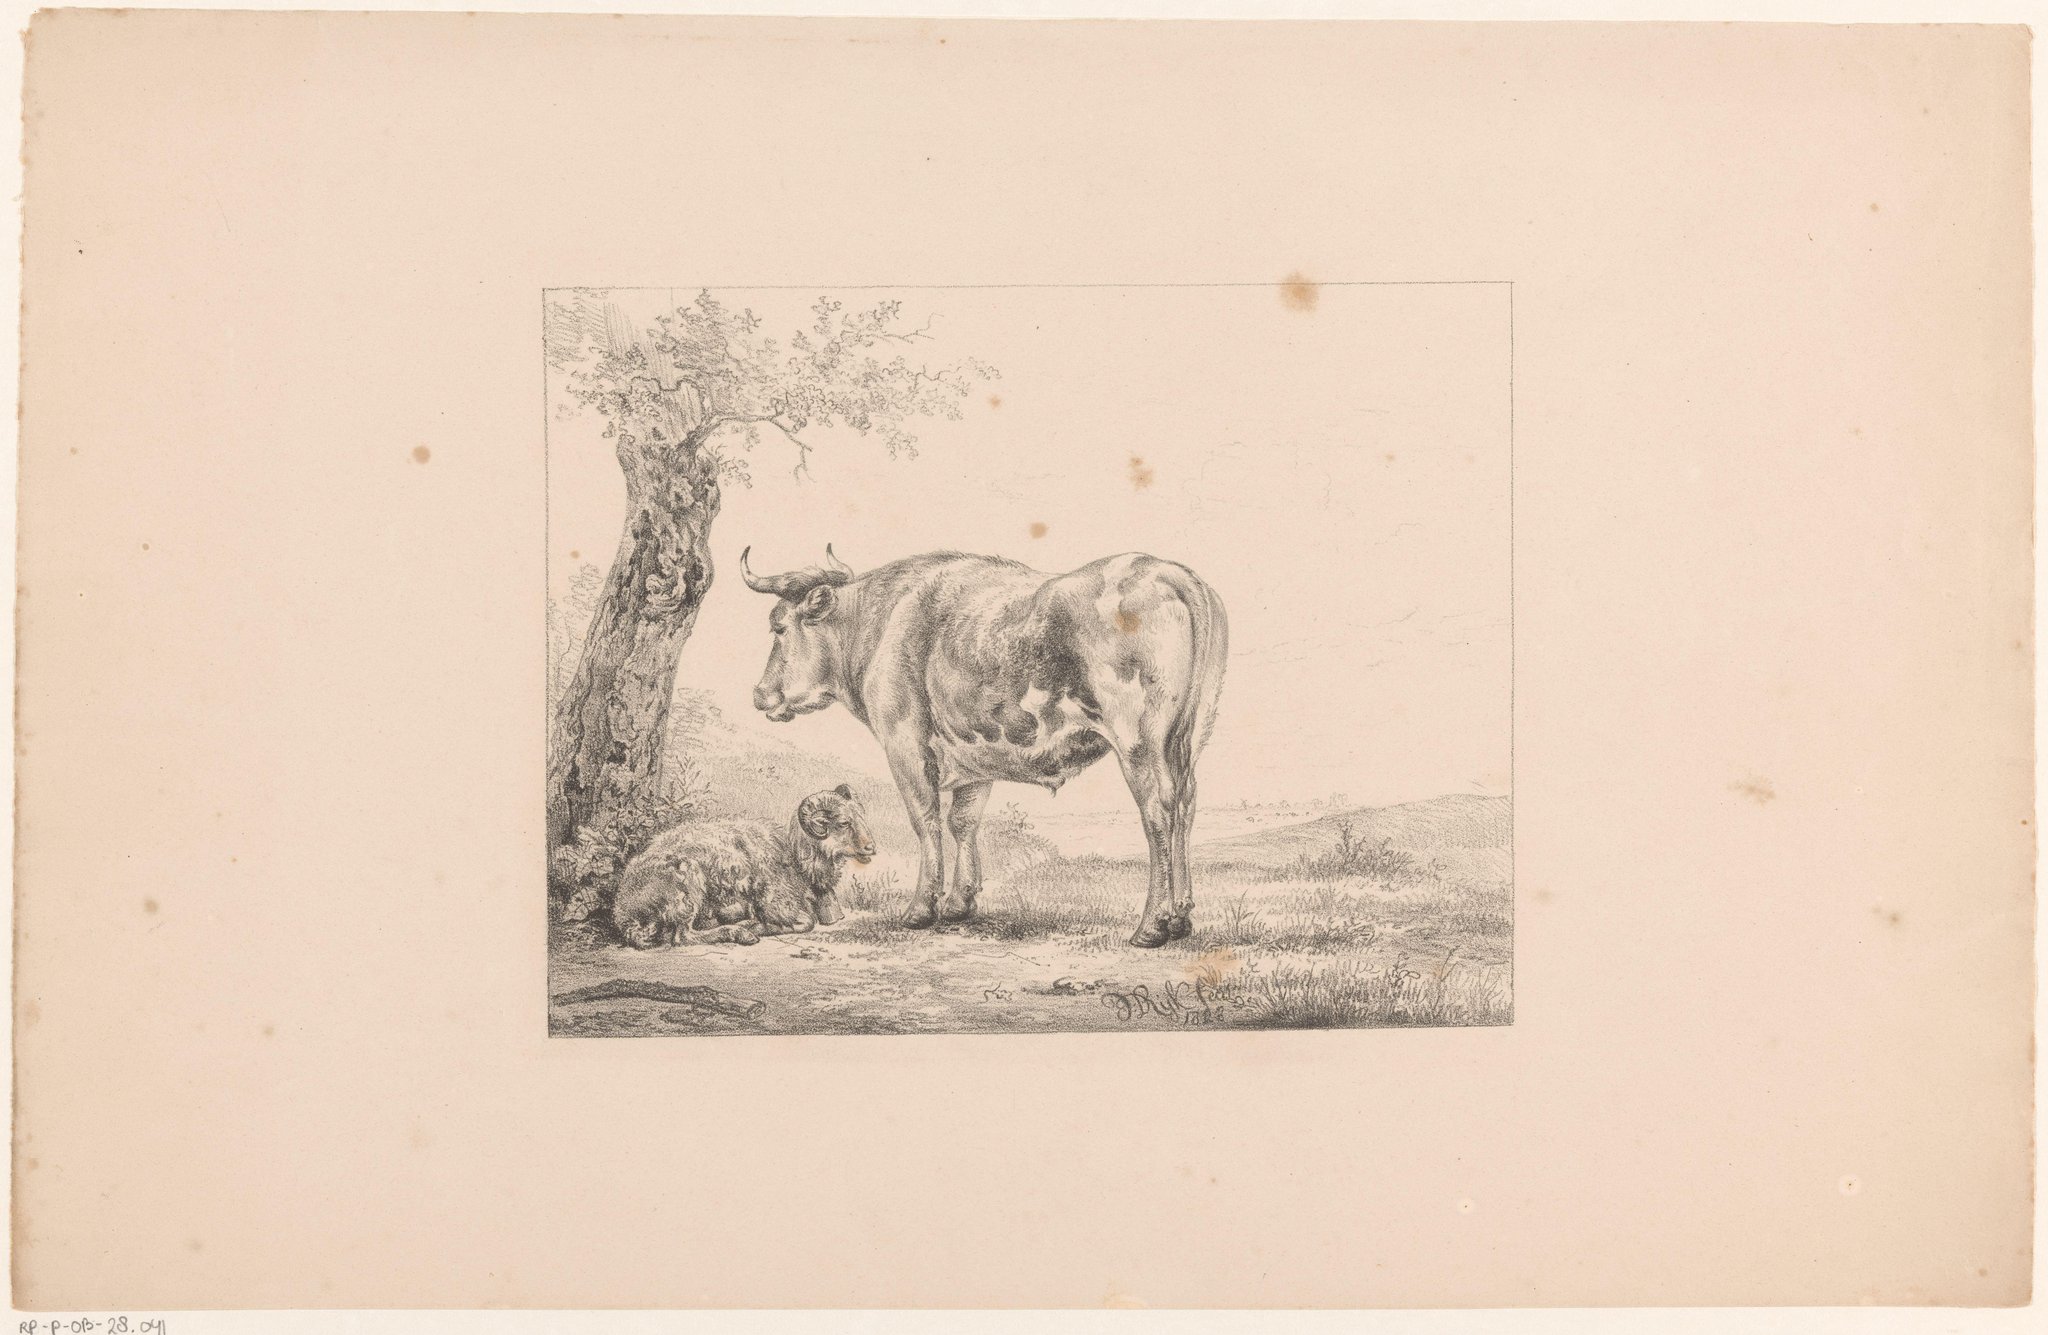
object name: print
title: Ram en stier in een landschap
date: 1823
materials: paper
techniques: lithograph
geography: amsterdam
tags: bull, ram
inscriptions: collector's mark: Lugt 2228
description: De ram ligt op de grond, de stier staat met zijn hoofd richting een boom.